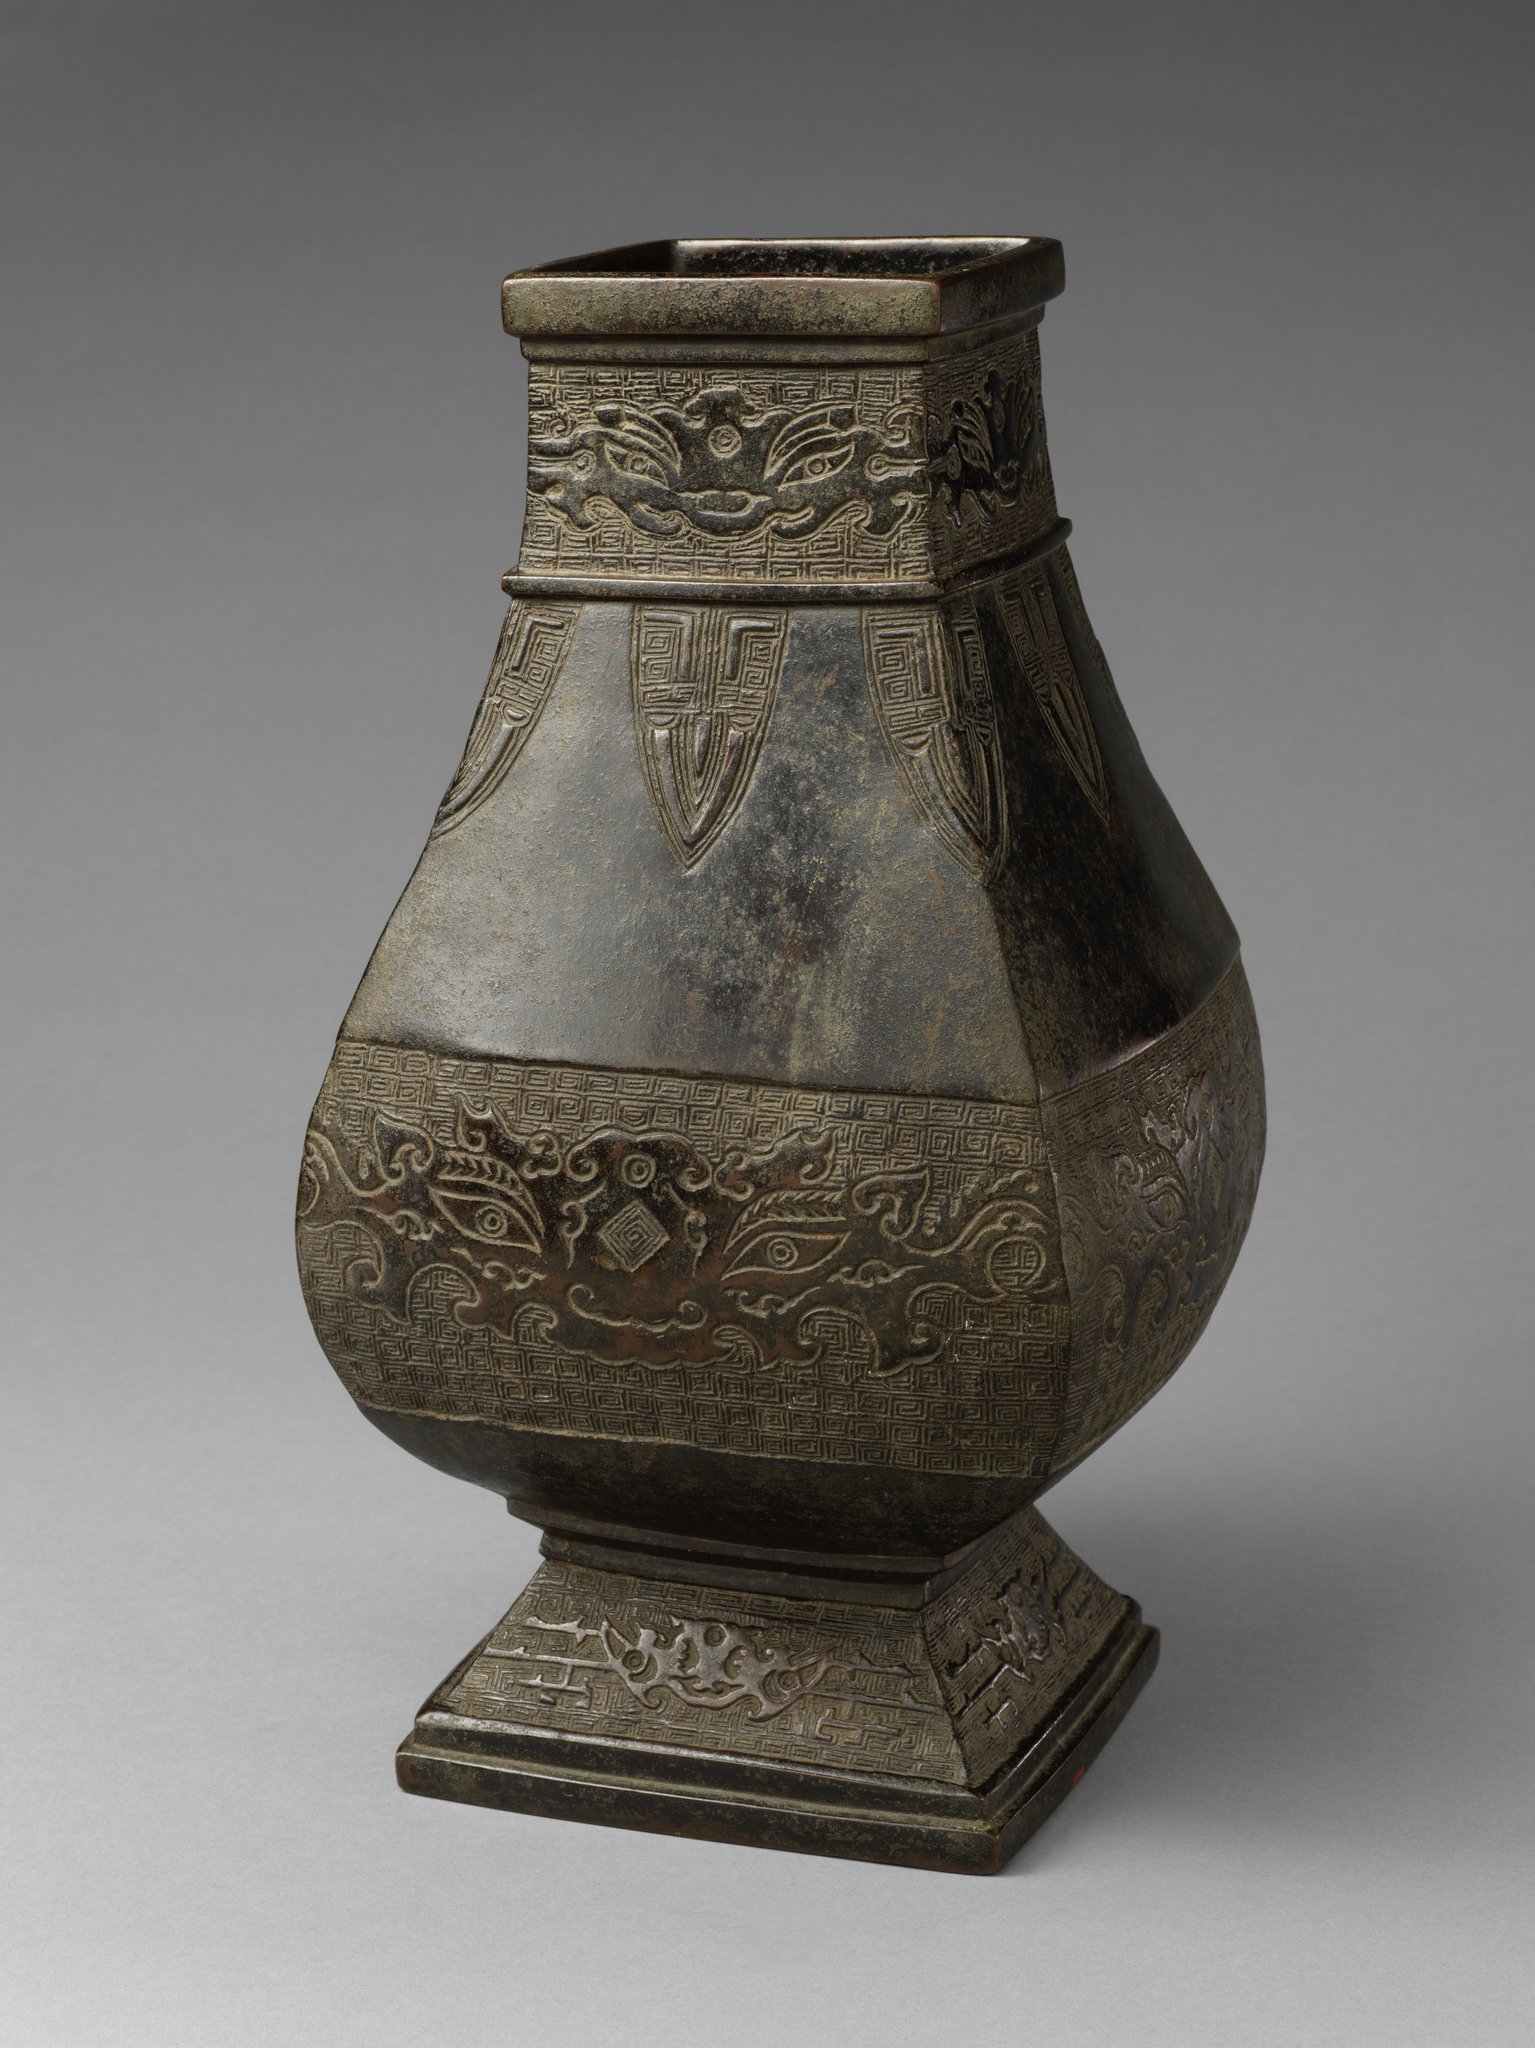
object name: vase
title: Vase with archaistic design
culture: chinese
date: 1701-1900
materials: copper alloy